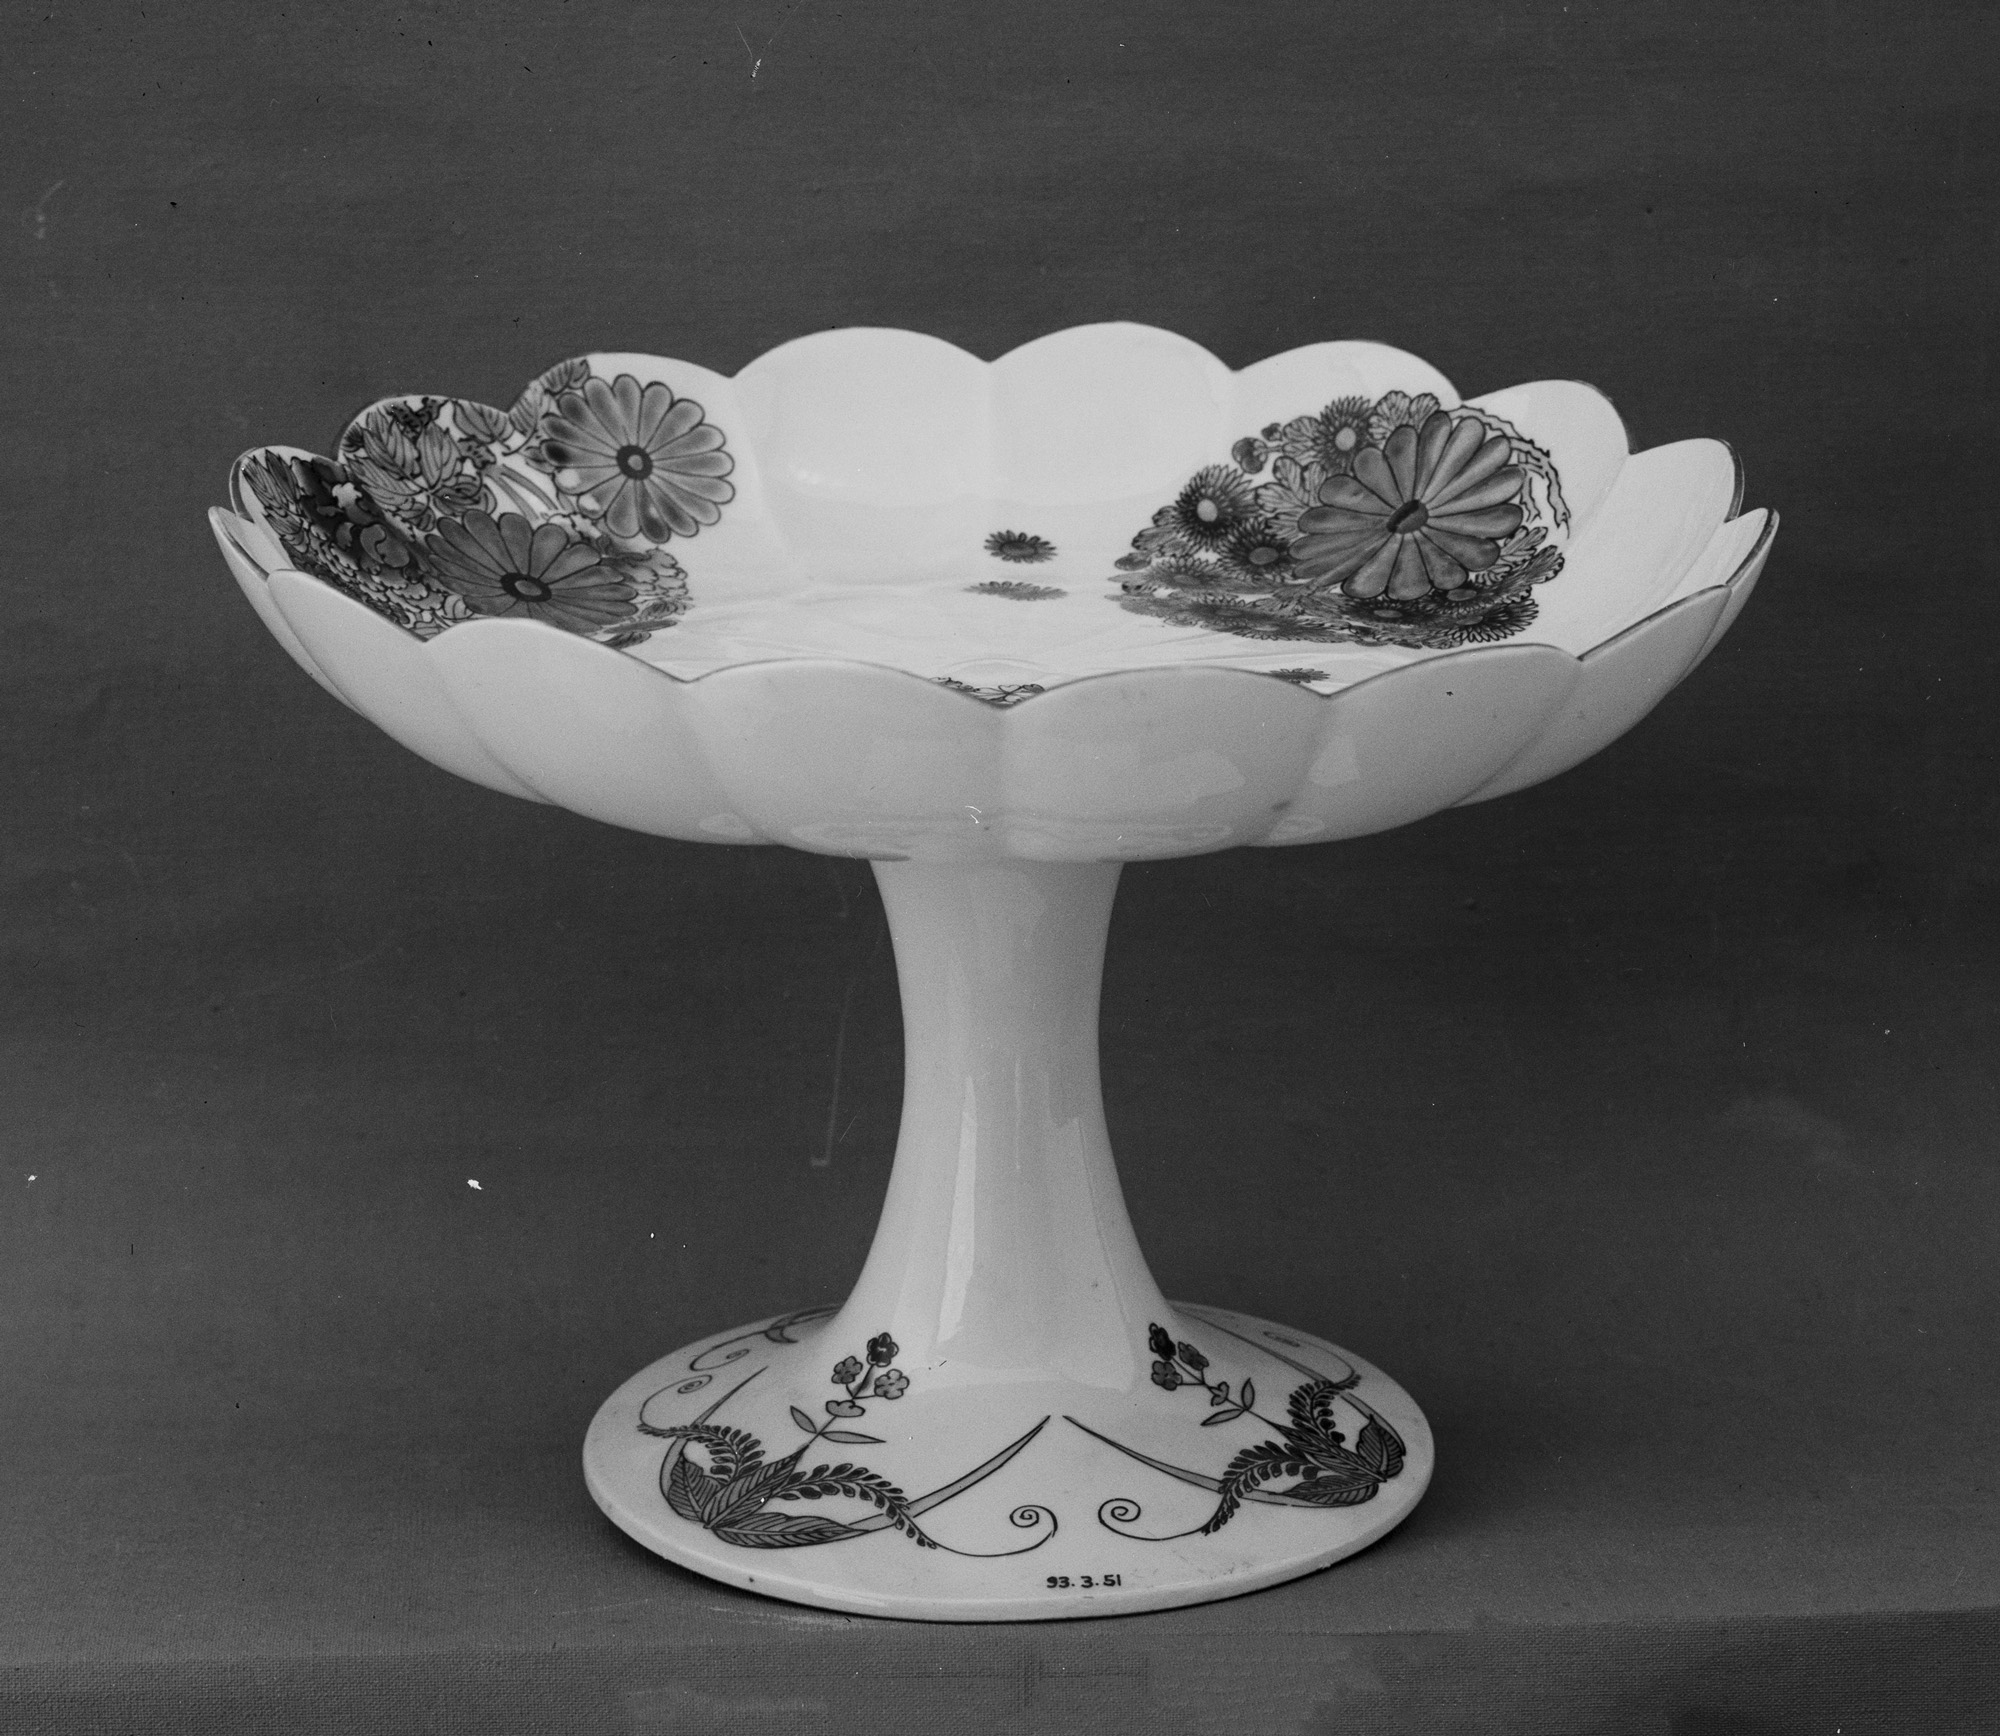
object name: dish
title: Dish on High Foot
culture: japanese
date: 1780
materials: enamel, porcelain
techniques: polychrome